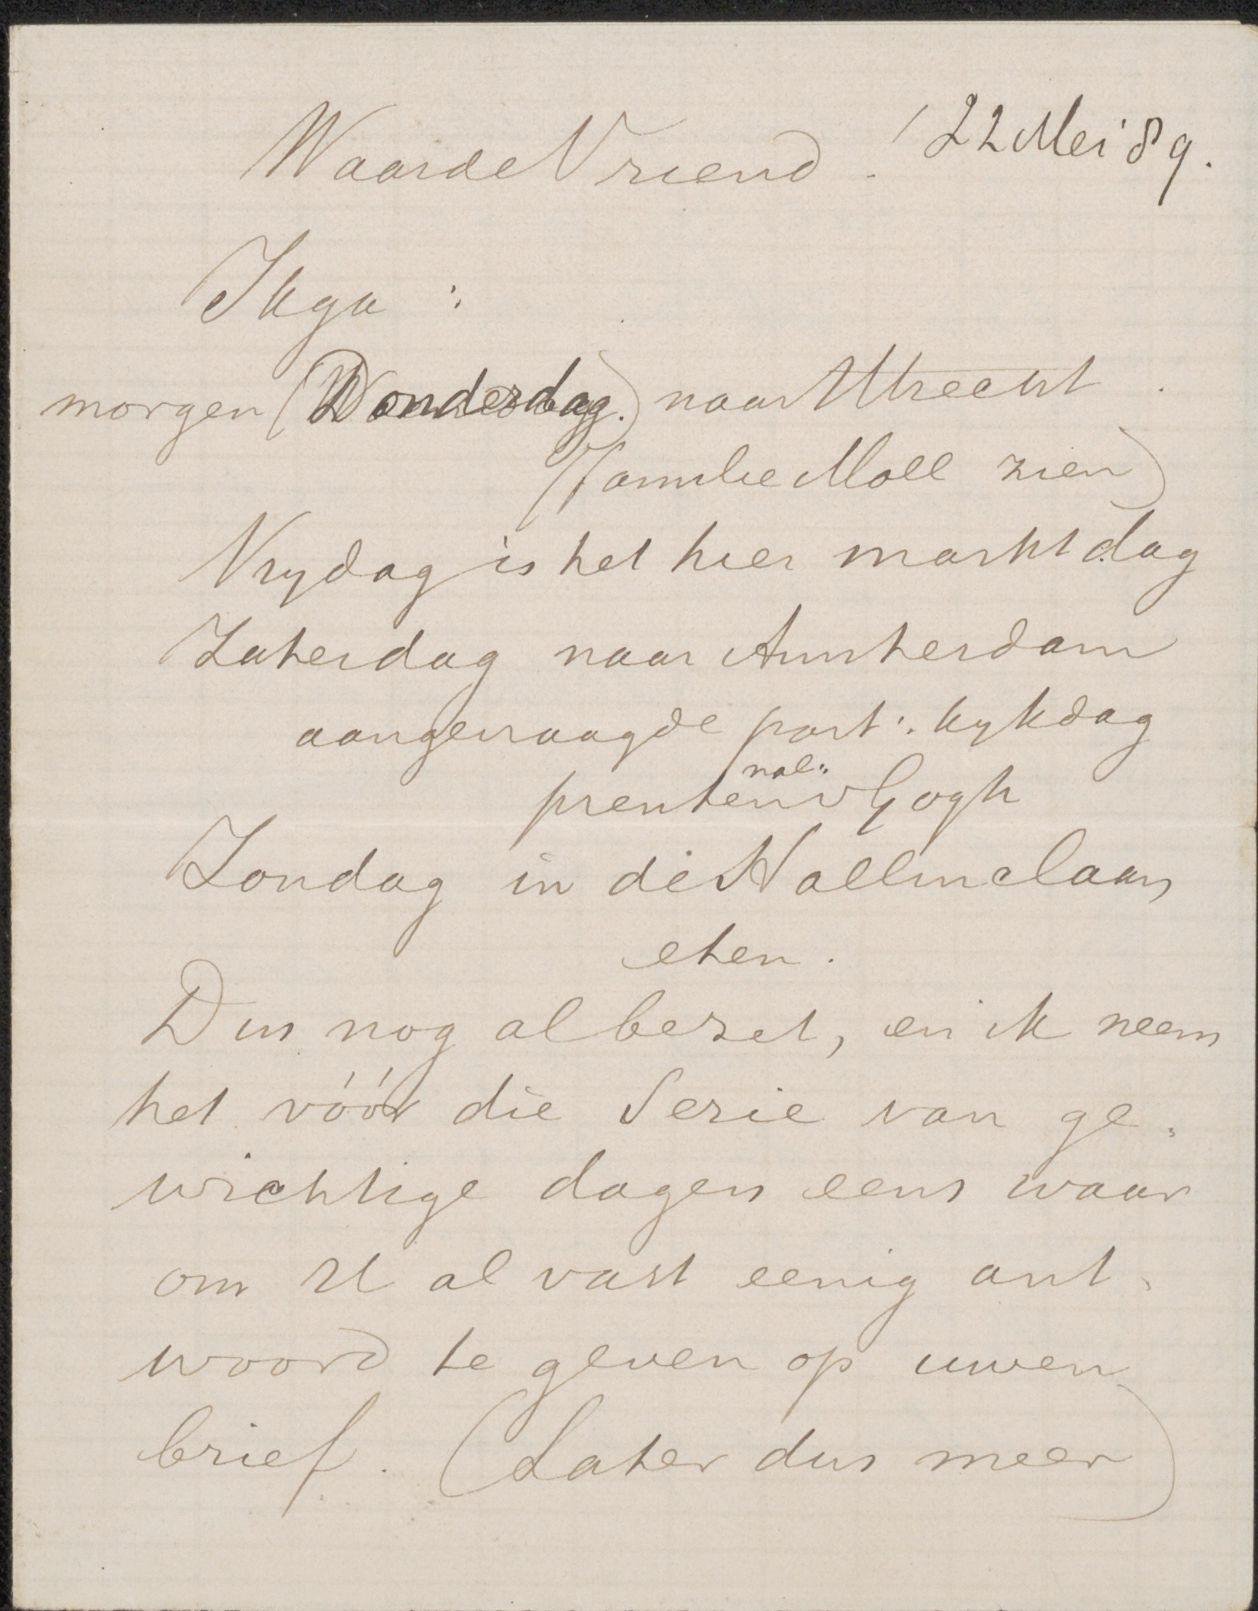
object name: letter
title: Brief aan Jan Veth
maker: martinus cornelis lebret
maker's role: verzamelaar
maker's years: 1833-1894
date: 1889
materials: ink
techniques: pen, writing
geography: dordrecht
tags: dordrecht, painter, draughtsman, designer, jan veth, the graphic arts, utrecht, amsterdam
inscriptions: collector's mark: ‘RPK’